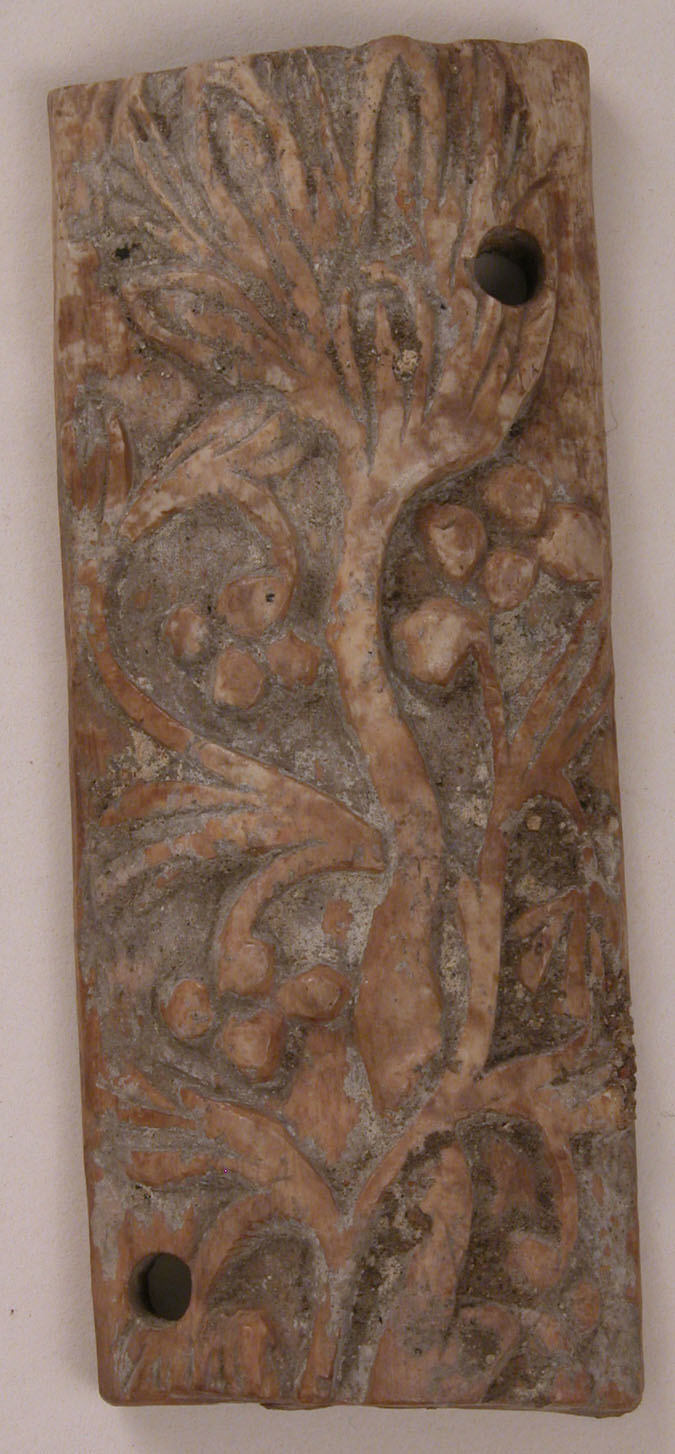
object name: plaque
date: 501-700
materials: bone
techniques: carving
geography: egypt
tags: leaves